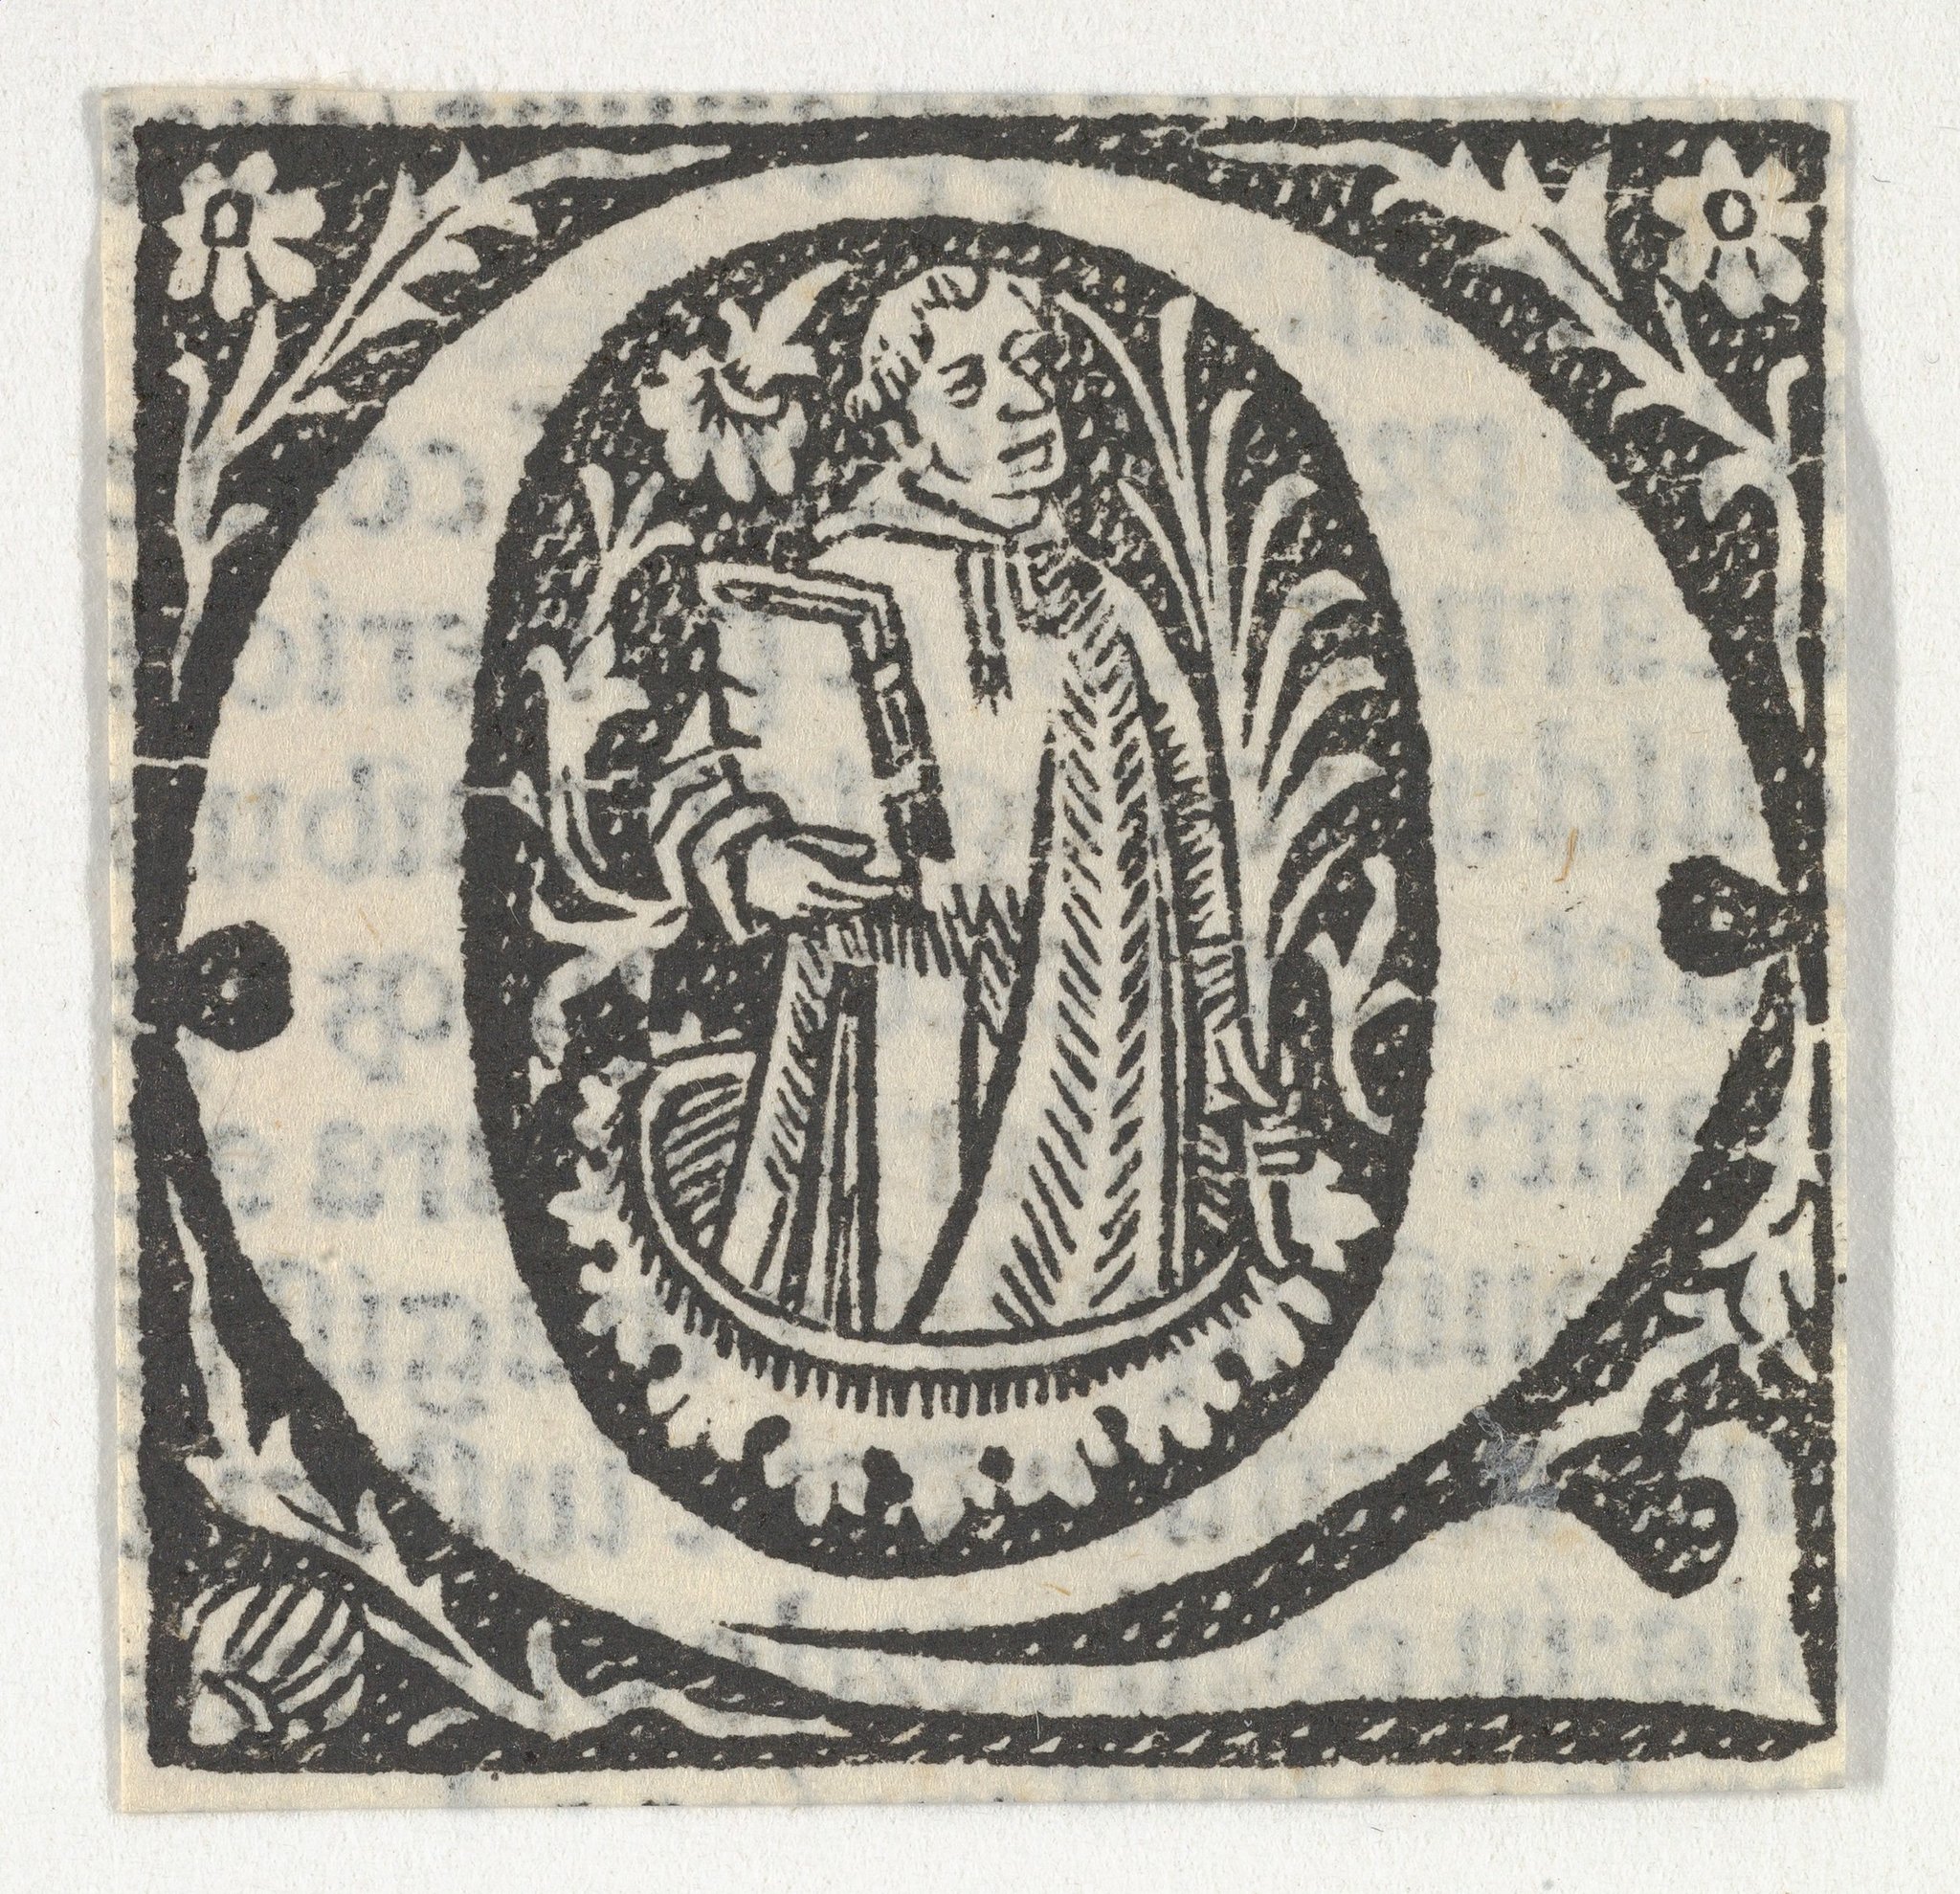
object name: print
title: Decorated Roman alphabet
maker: anonymous, french, 15th century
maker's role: artist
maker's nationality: french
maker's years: 1400-1500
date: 1499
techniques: woodcut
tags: men,portraits